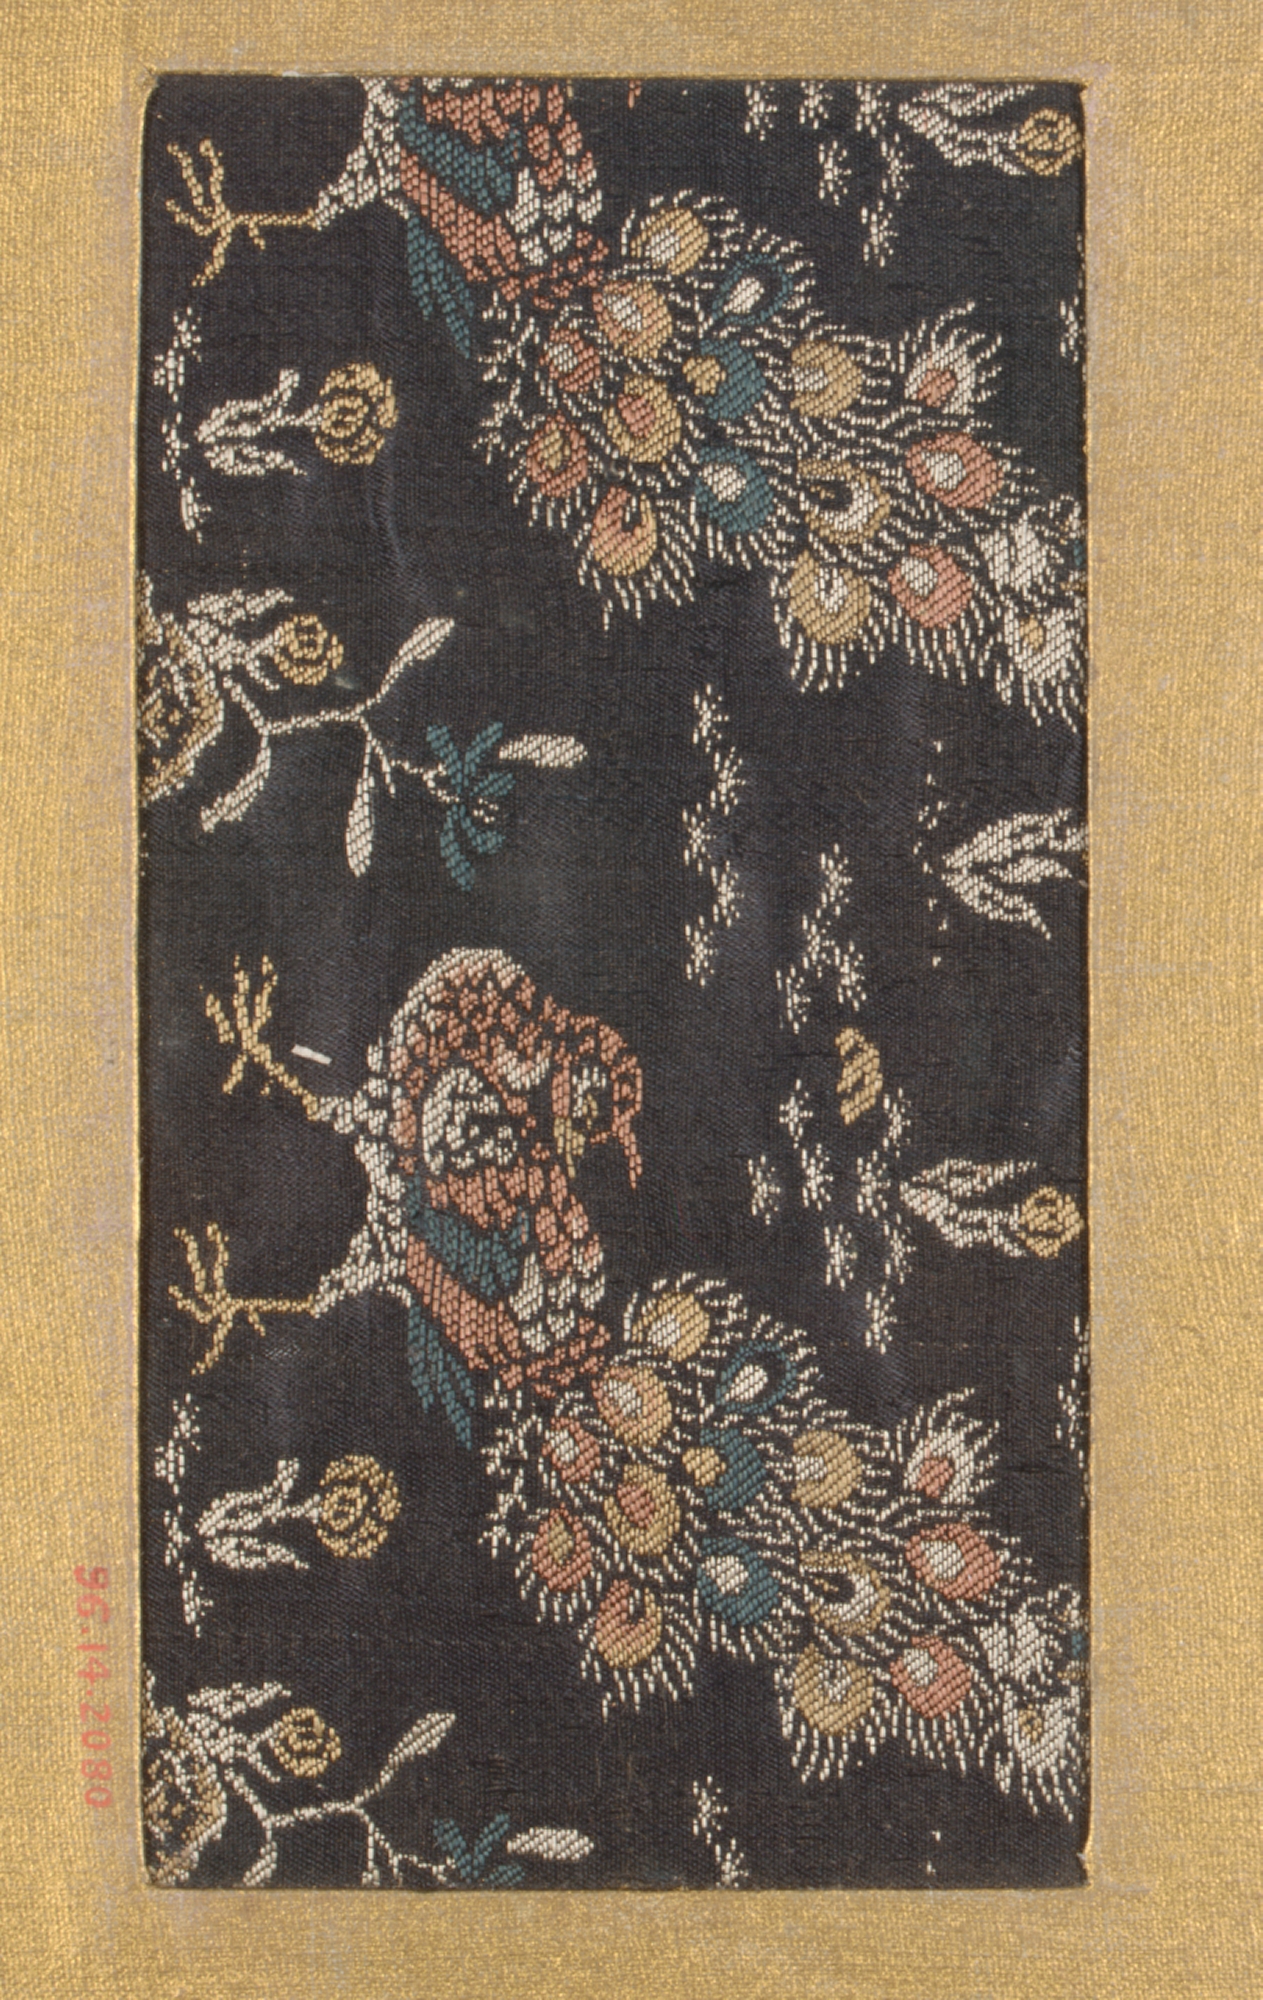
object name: piece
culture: japanese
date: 1701-1900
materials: silk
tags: peacocks